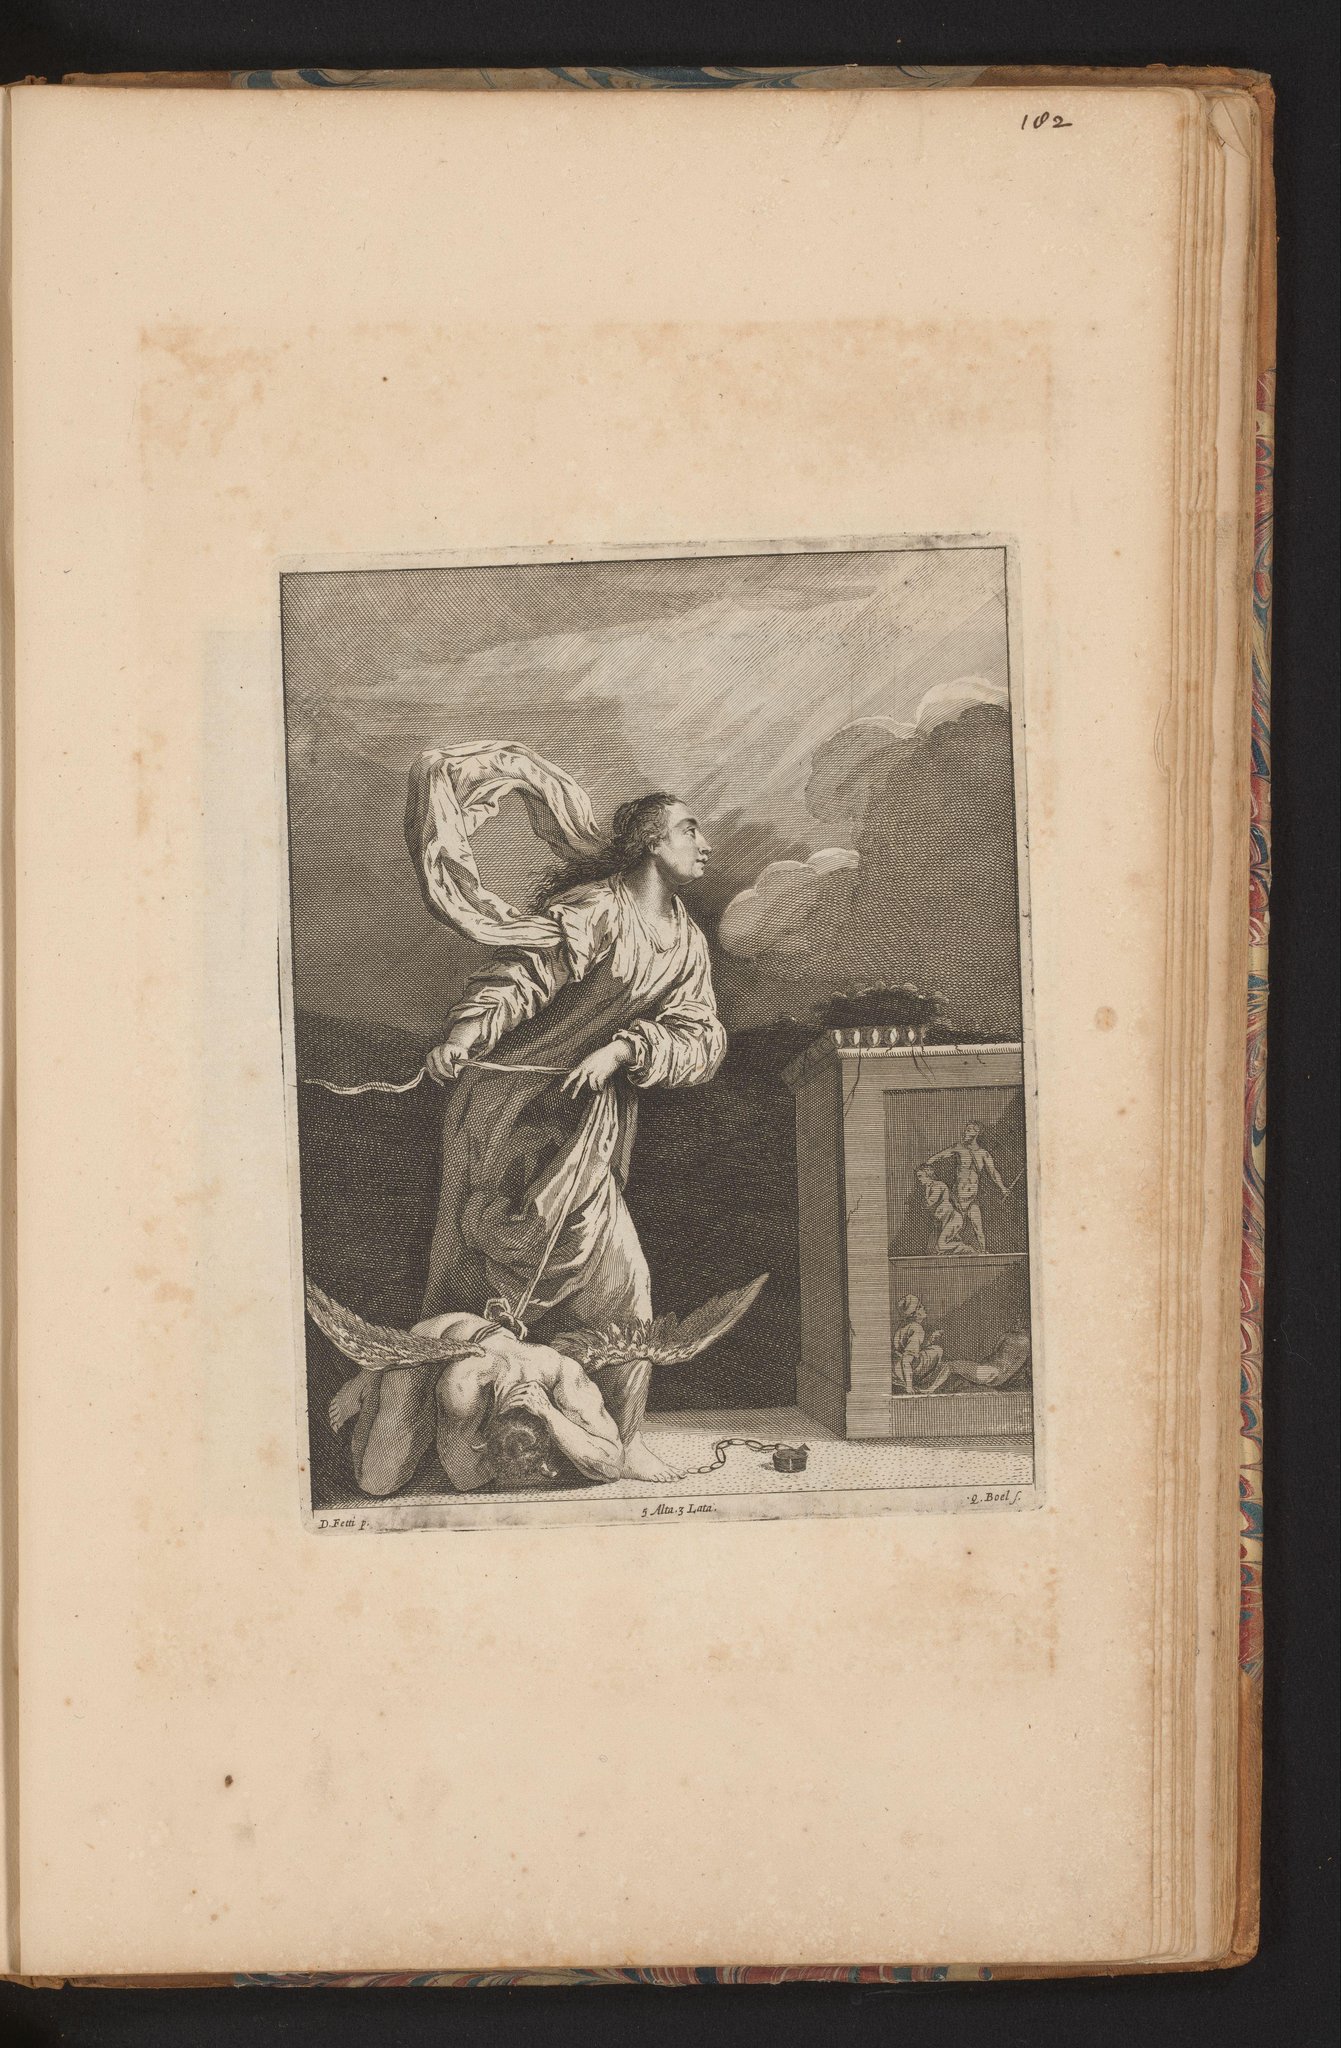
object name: album leaf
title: H. Juliana van Nicodemië verslaat de duivel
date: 1660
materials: paper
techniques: etching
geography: italy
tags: st. juliana overpowering the devil: she chains or binds him and drags him to the latrine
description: De prent is vervaardigd naar het schilderij naar Fetti dat zich in de collectie van het Kunsthistorisches Museum te Wenen bevindt (inventarisnummer GG_1614). David Teniers heeft waarschijnlijk van alle schilderijen uit de collectie van Leopold Willem van Oostenrijk een olieverfstudie op doek of paneel vervaardigd (zgn. pasticcio), die als voorbeeld voor de prentmakers diende. Het is niet altijd duidelijk of de pasticci door hem zijn gemaakt of door zijn atelier. Niet alle pasticci zijn overgeleverd.